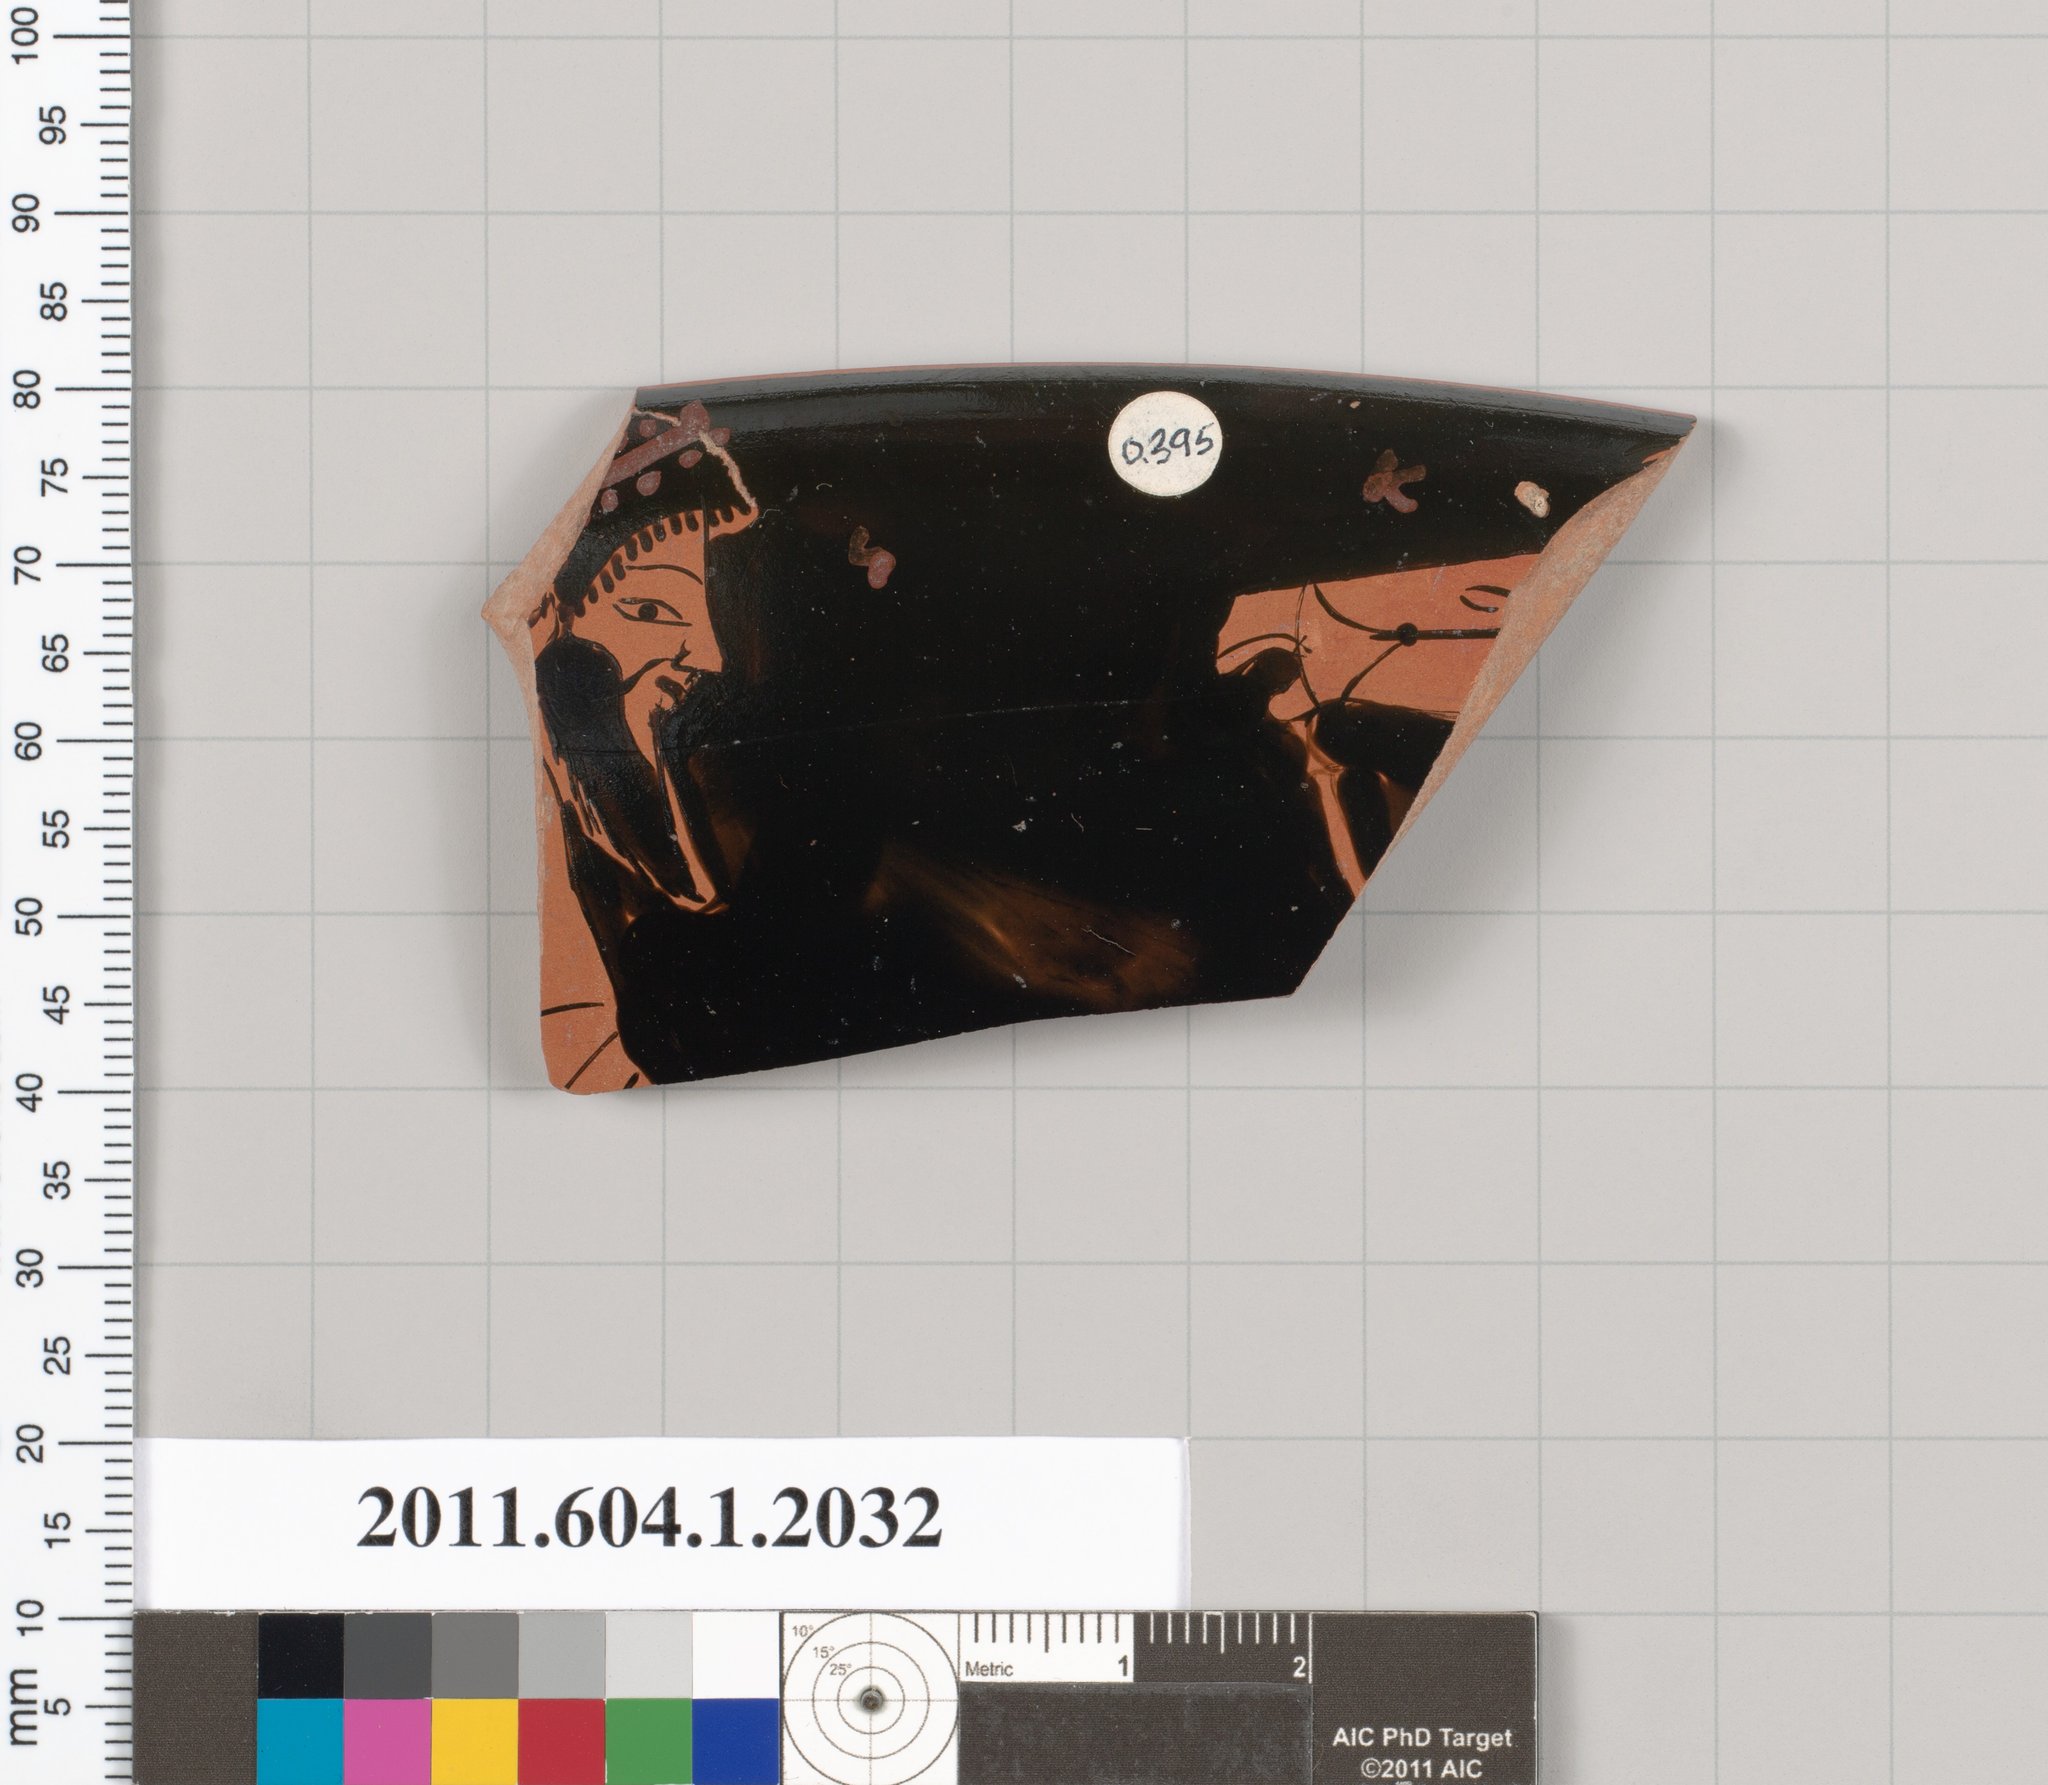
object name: kylix fragment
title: Terracotta rim fragment of a kylix (drinking cup)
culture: greek, attic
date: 500-480 BCE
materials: terracotta